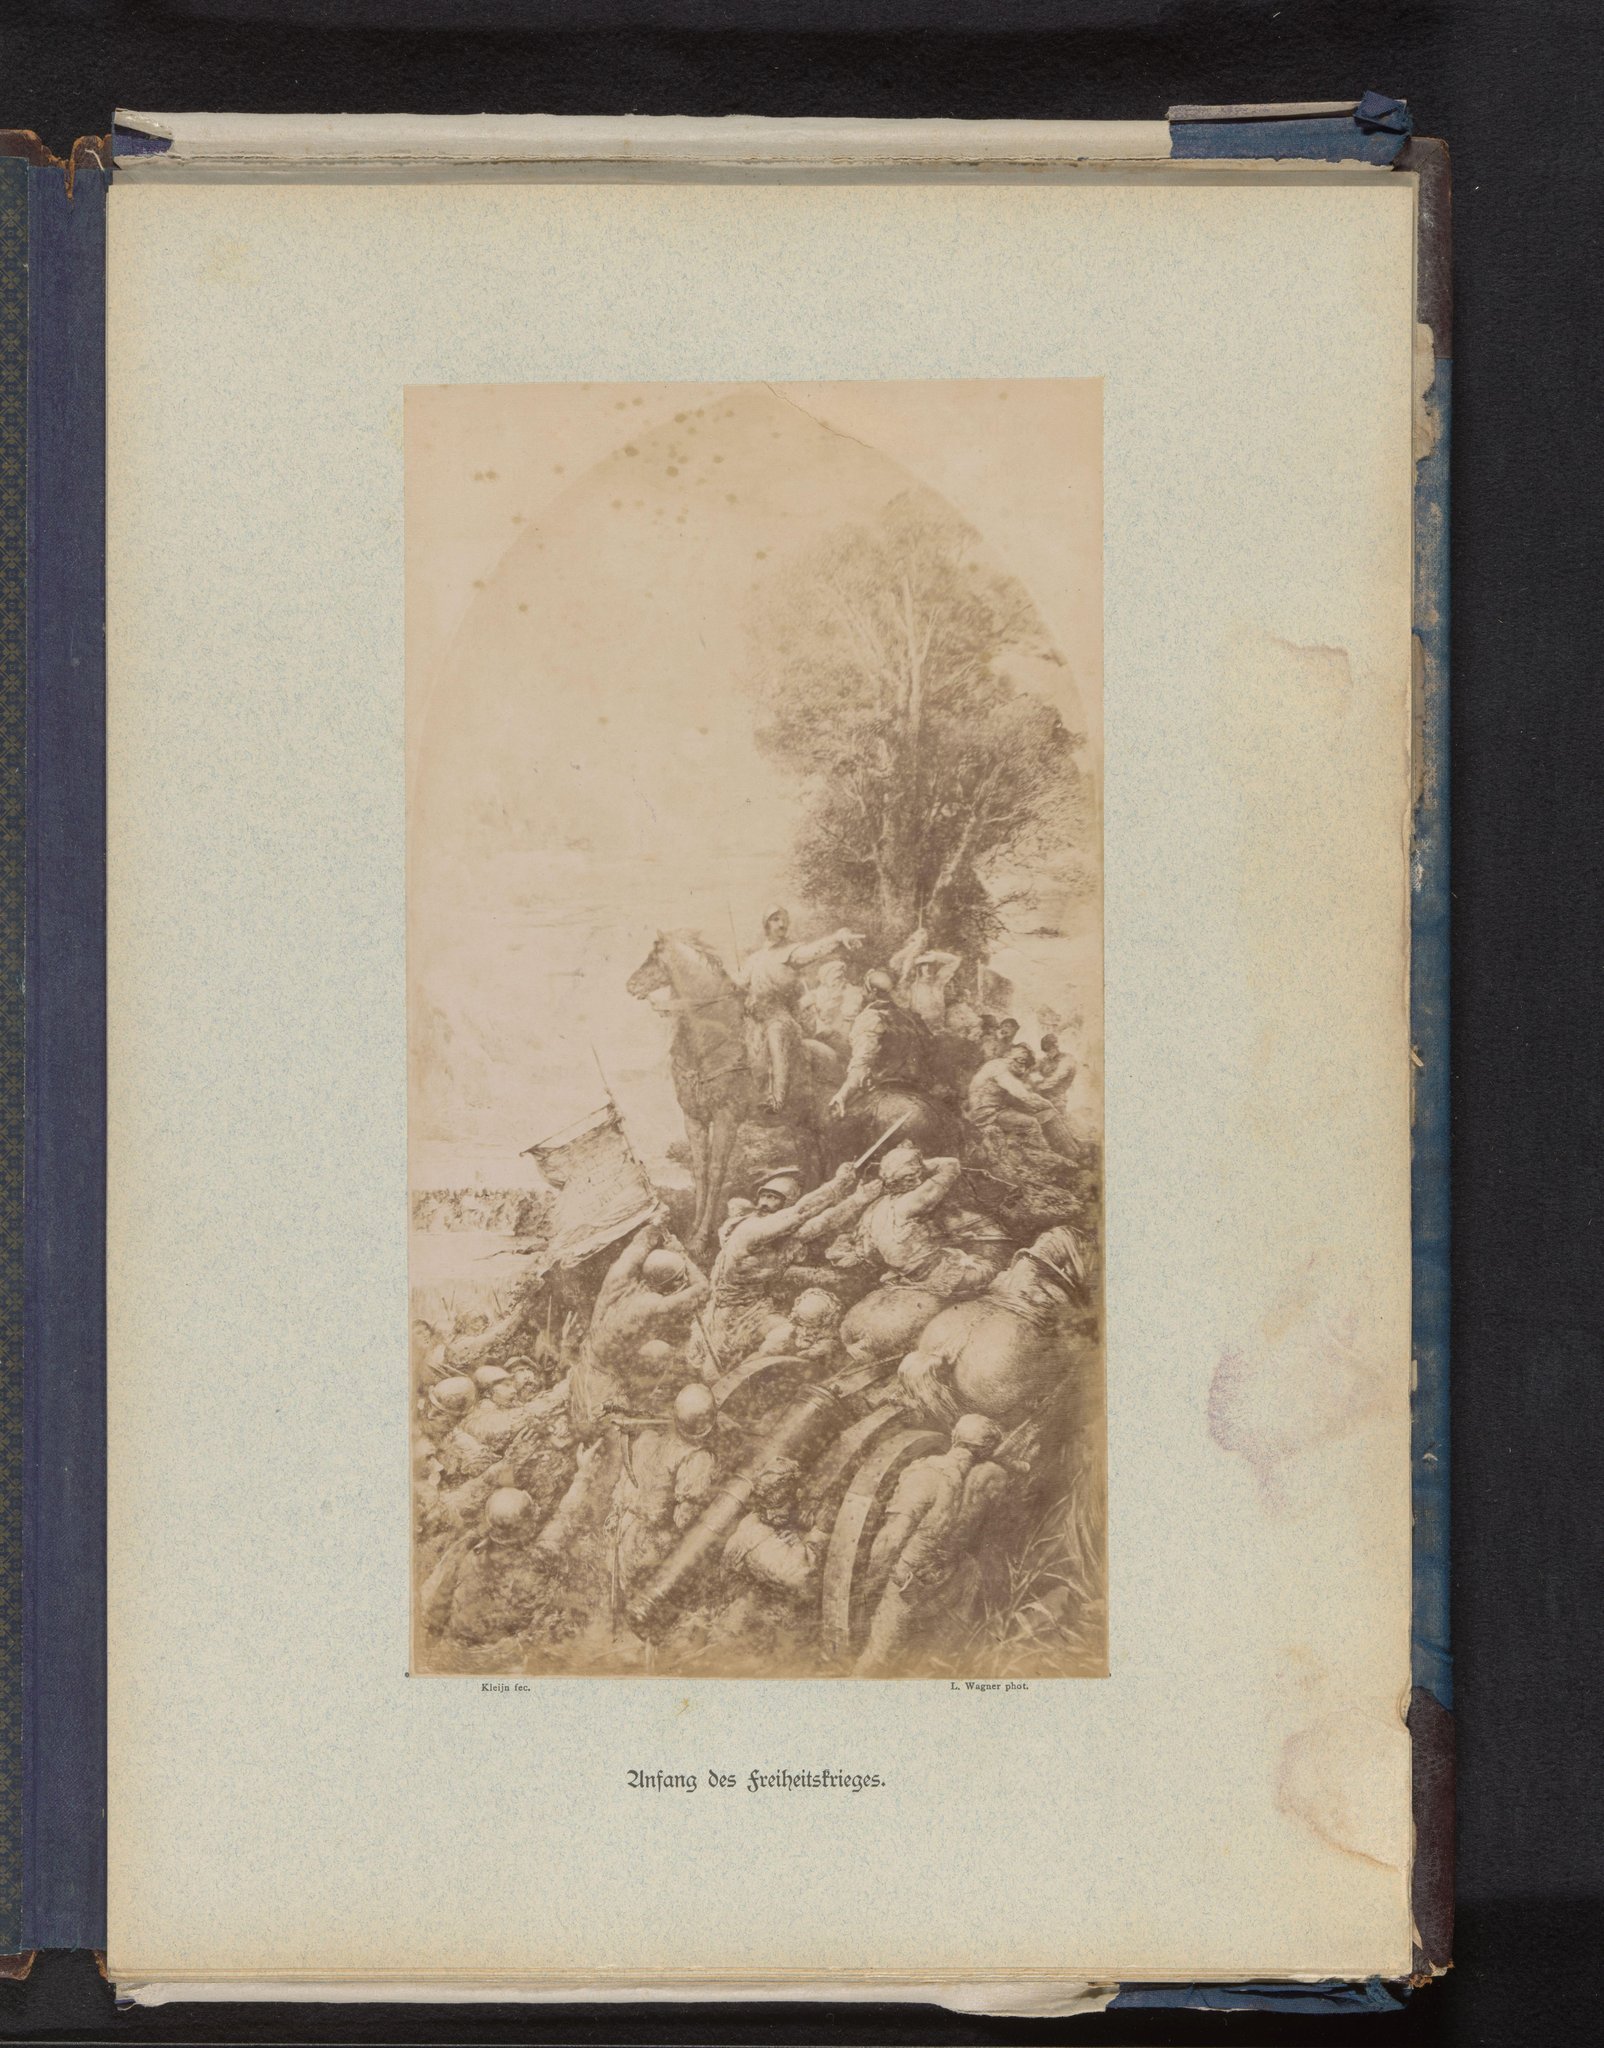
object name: photograph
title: Anfang des Freiheitsfrieges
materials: photographic support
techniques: albumen print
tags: delft, william i (prince of orange), riding a horse, ass, or mule; rider, horseman, revolution, revolt, belgium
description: Deze foto maakt deel uit van een omslag met acht foto's op acht bladen en twee tekstbladen.